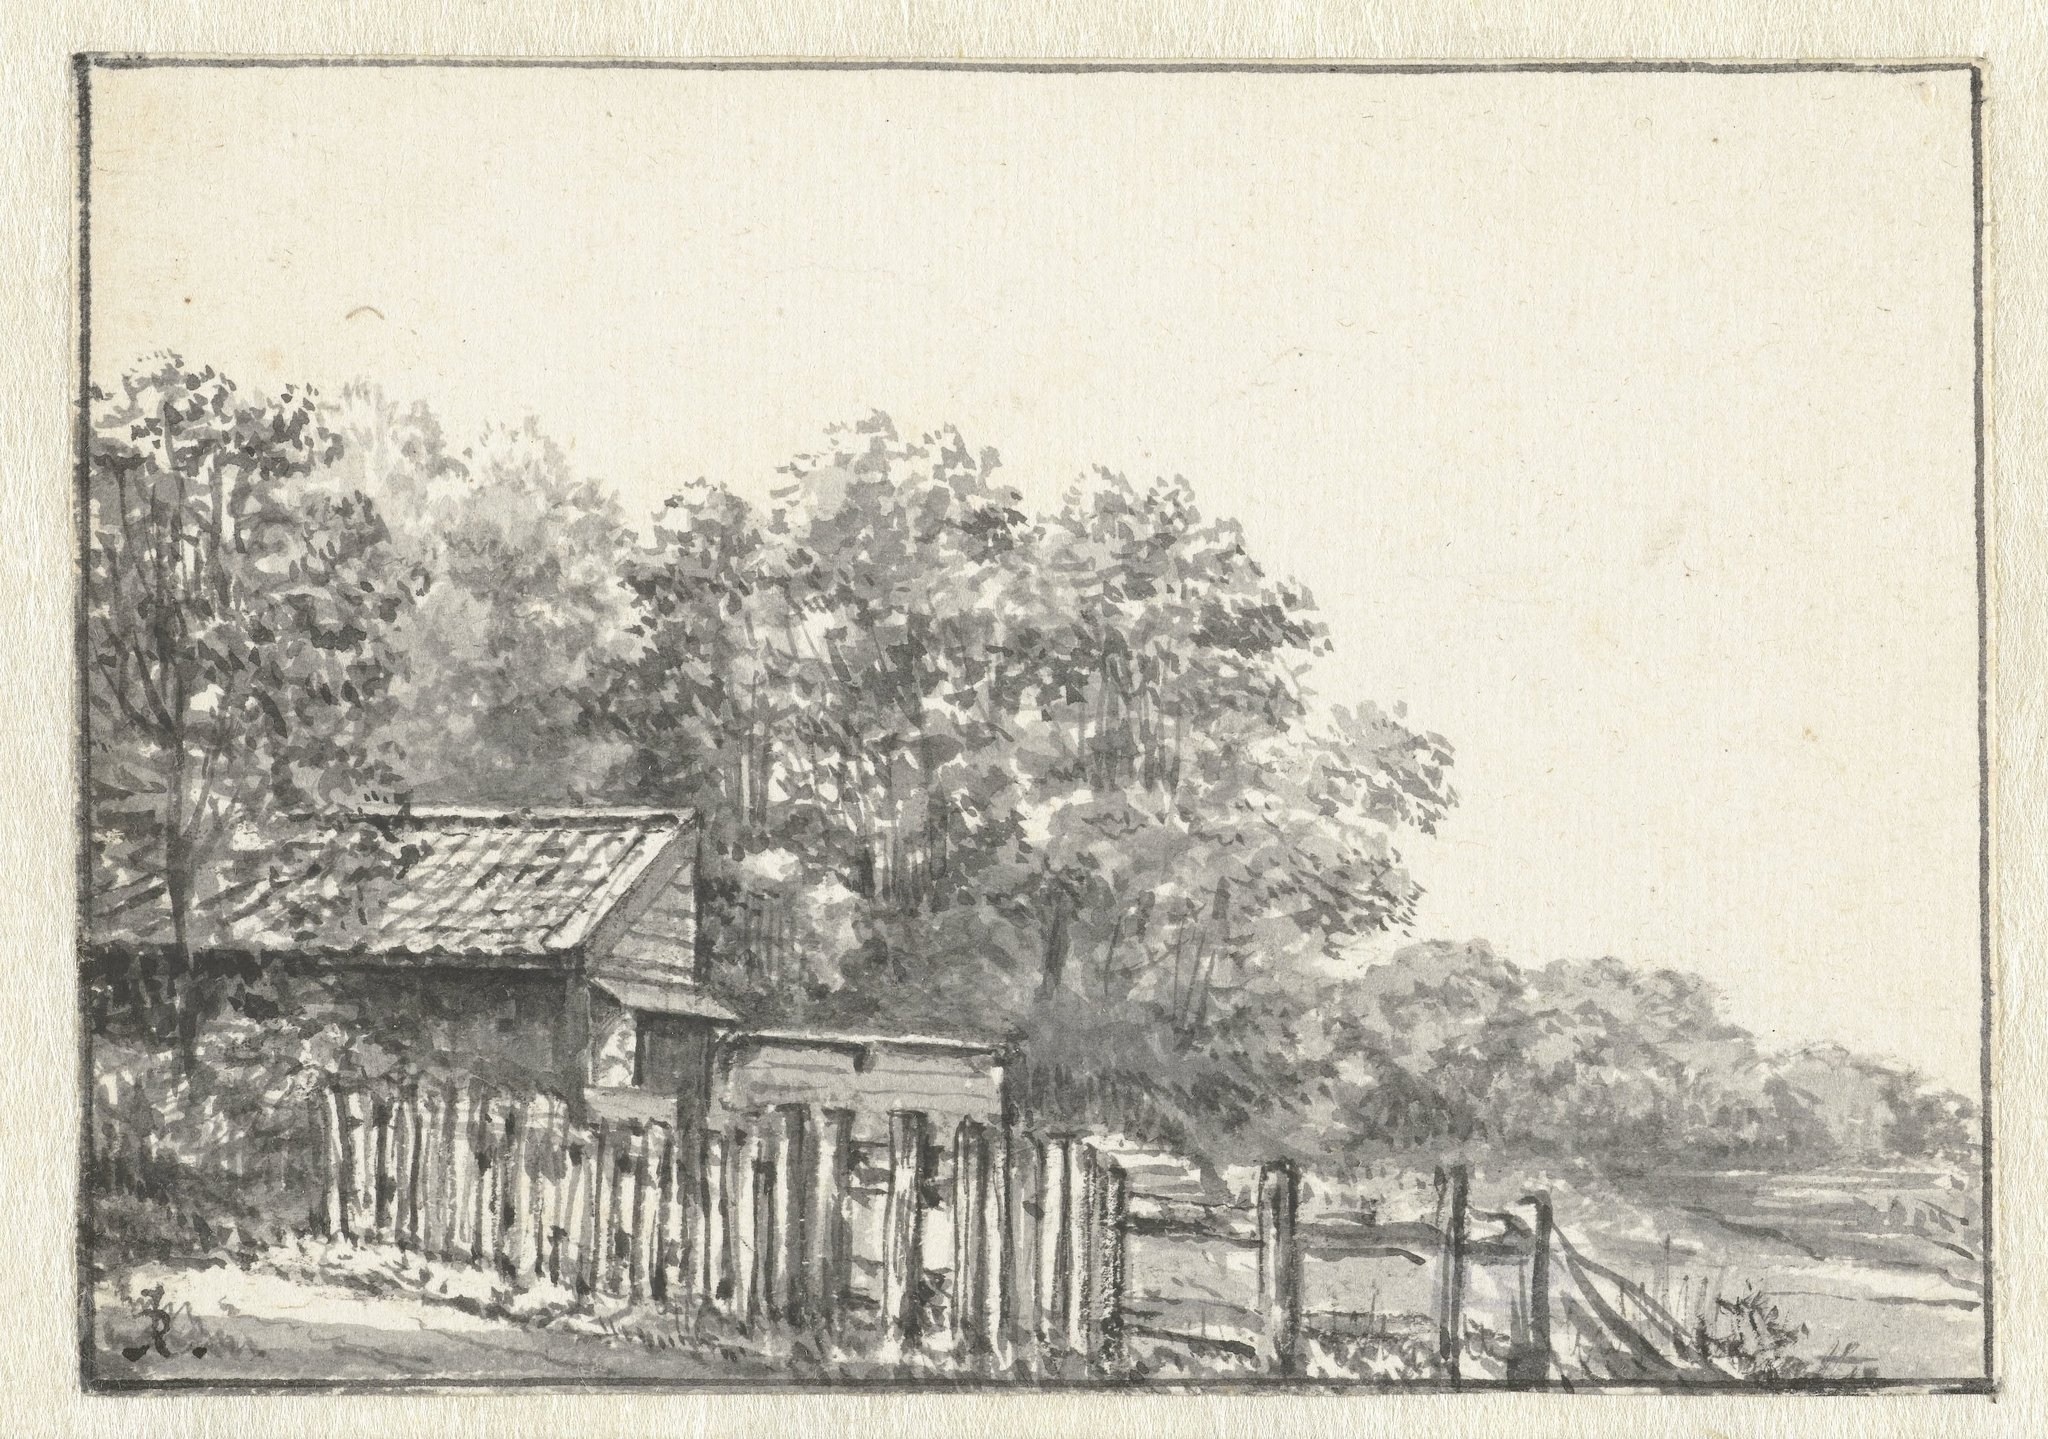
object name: drawing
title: Landschap met schuur en schutting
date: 1638-1682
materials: ink, paper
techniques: brush, pen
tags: coast, farm (building)